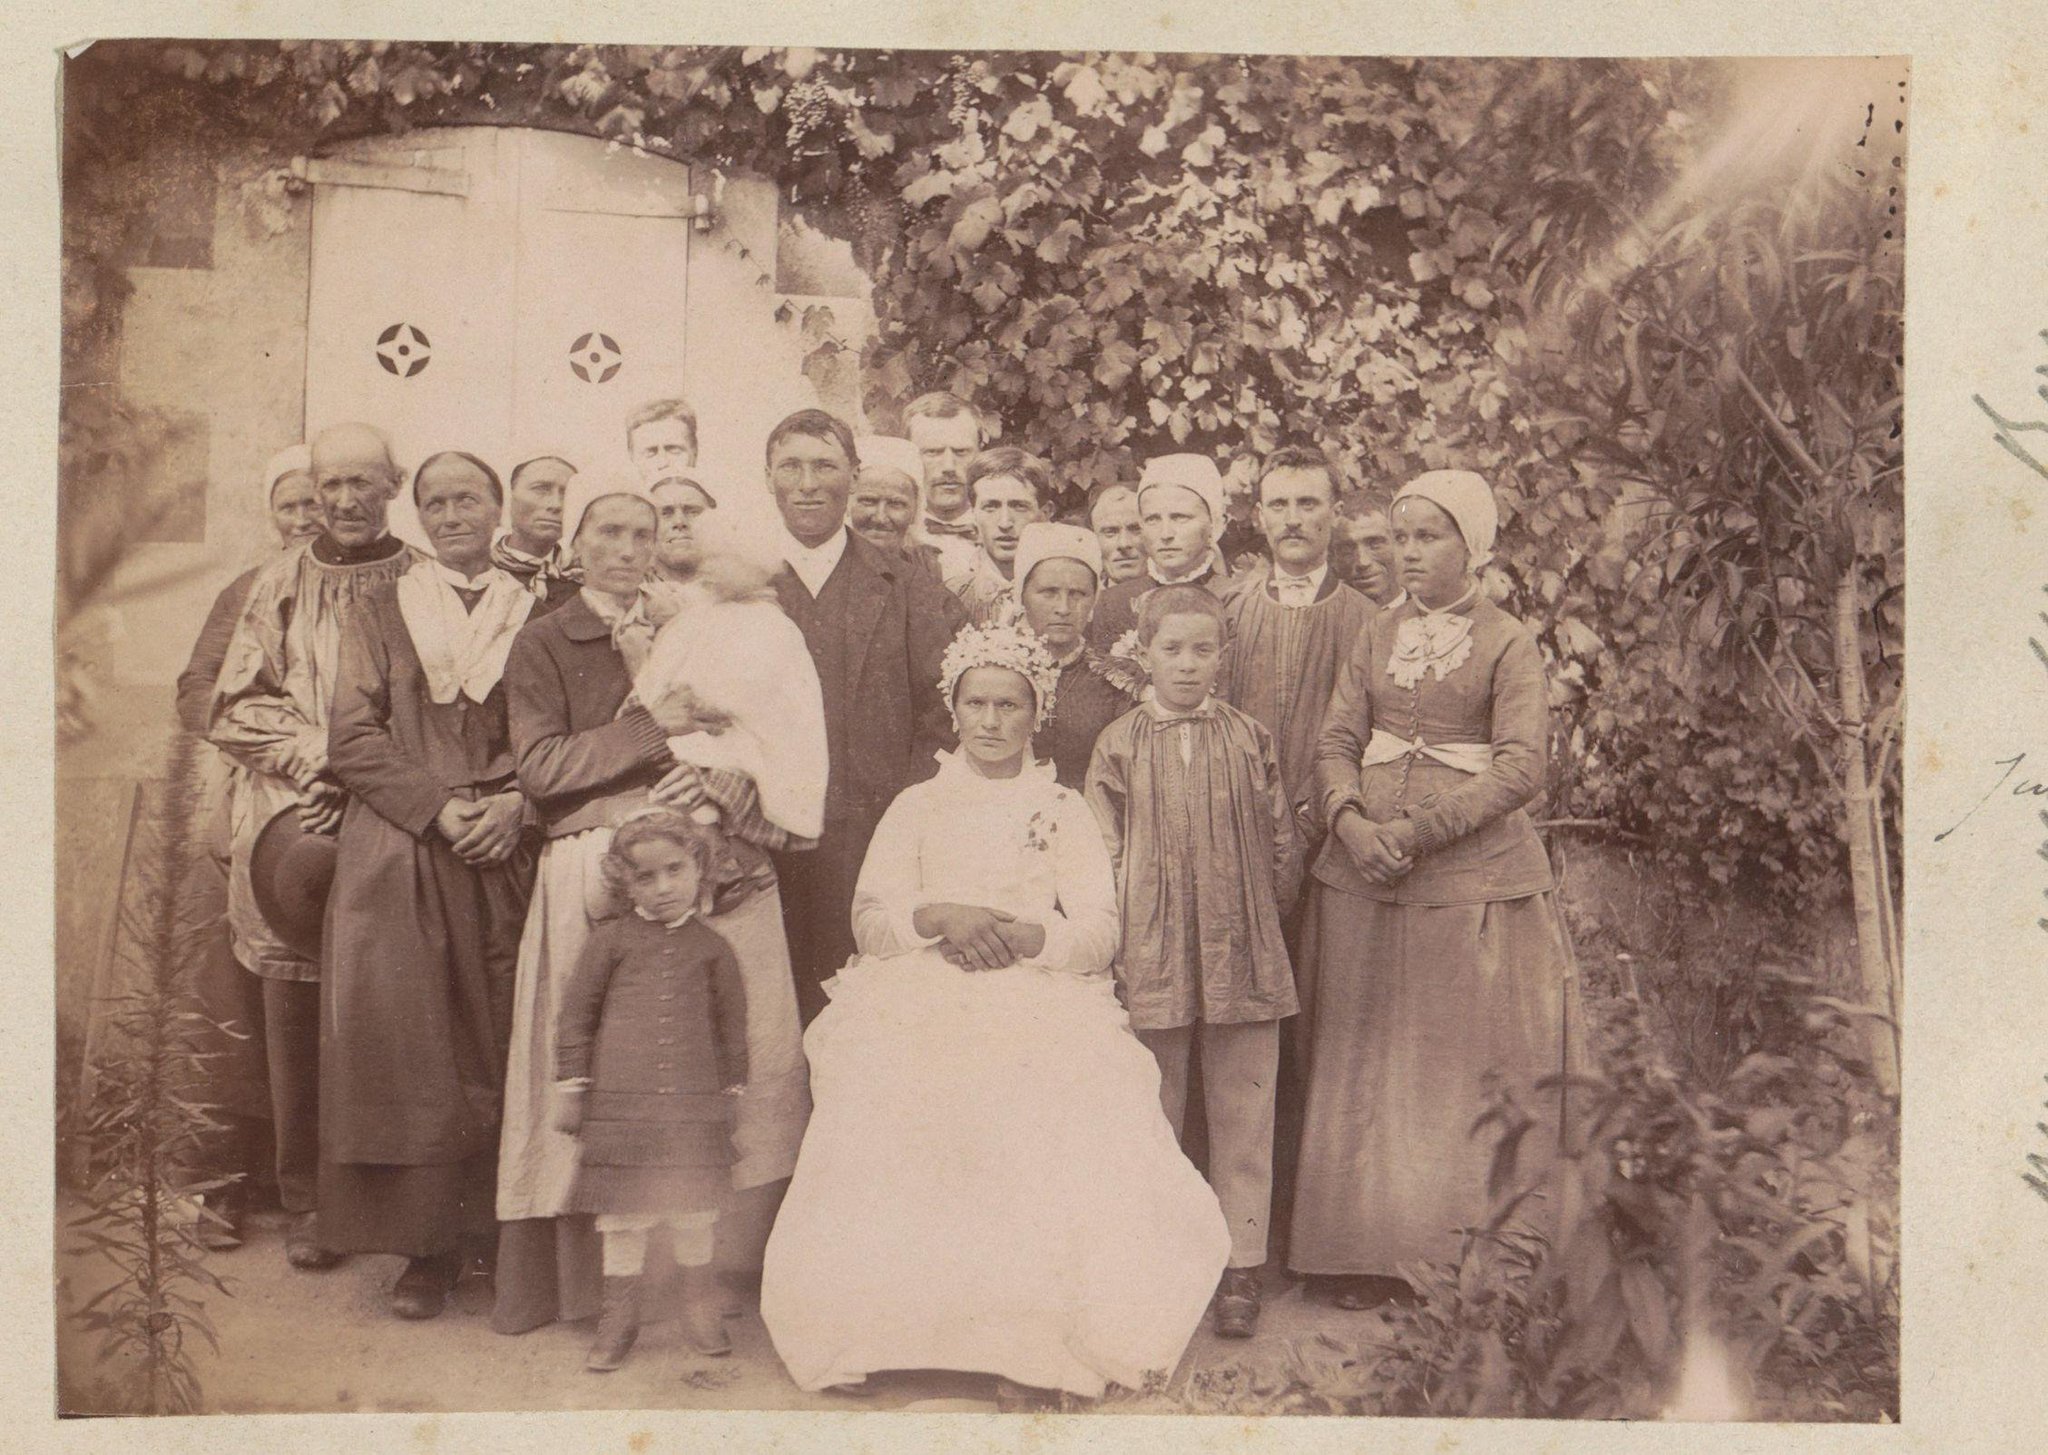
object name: photograph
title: Groepsportret van een Frans boerengezelschap, mogelijk bij een huwelijk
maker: Anonymous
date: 1807-1885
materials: photographic support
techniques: albumen print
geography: france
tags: three generations (family group)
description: Onderdeel van Album van een Franse amateurfotograaf met opnames van familie, militairen, industrie, landschappen en bezienswaardigheden in Frankrijk.